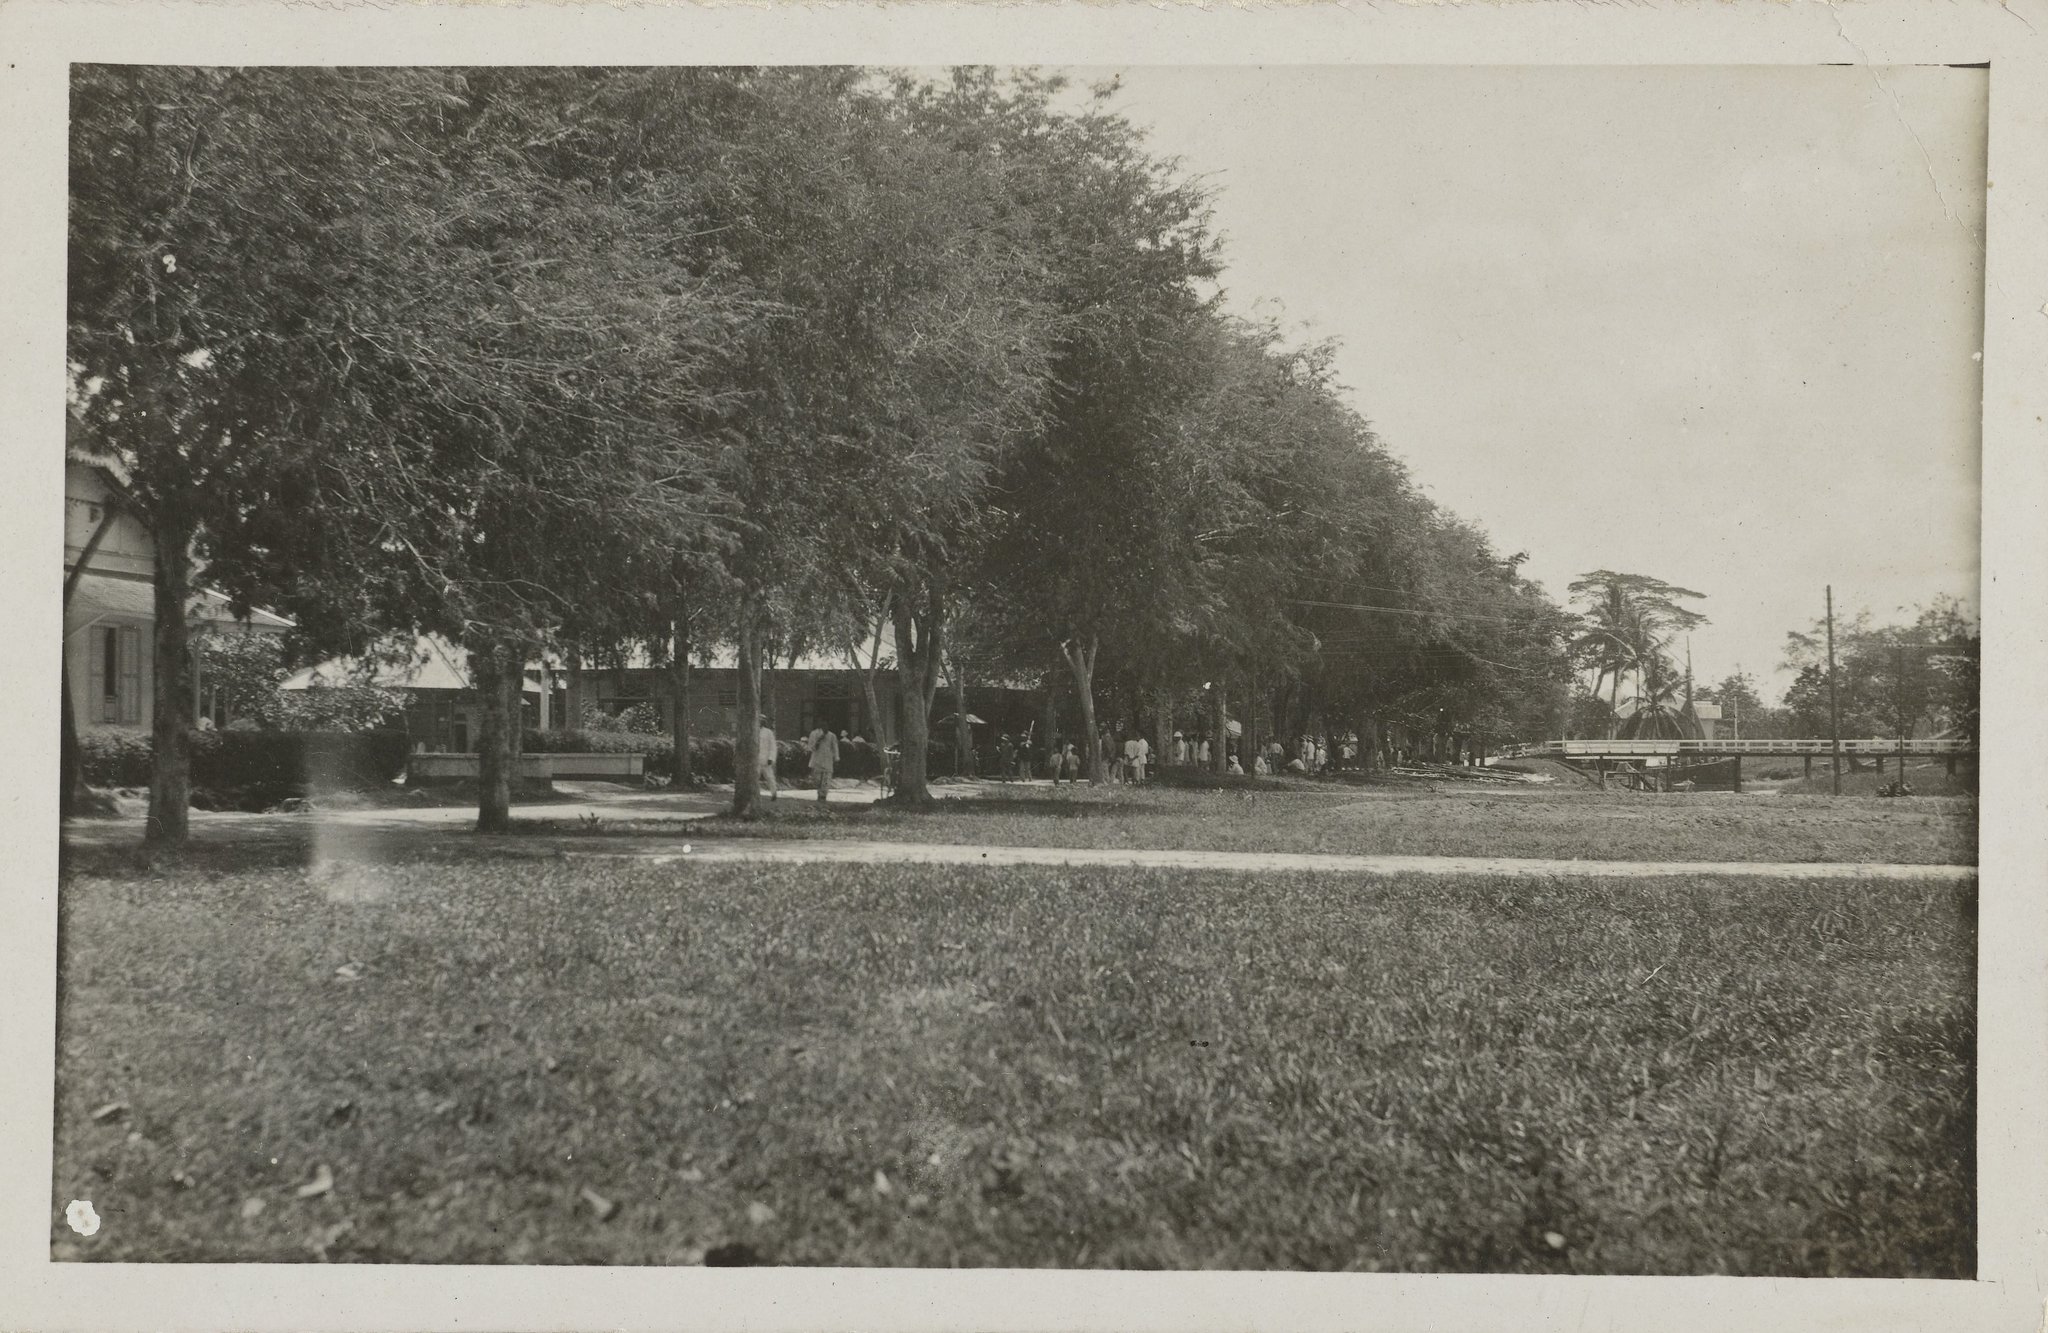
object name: photograph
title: Zicht over een veld in Sinkawang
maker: Anonymous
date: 1920-1940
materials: photographic support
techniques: gelatin silver print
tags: borneo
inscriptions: annotation: ‘Post card, correspondence address only’